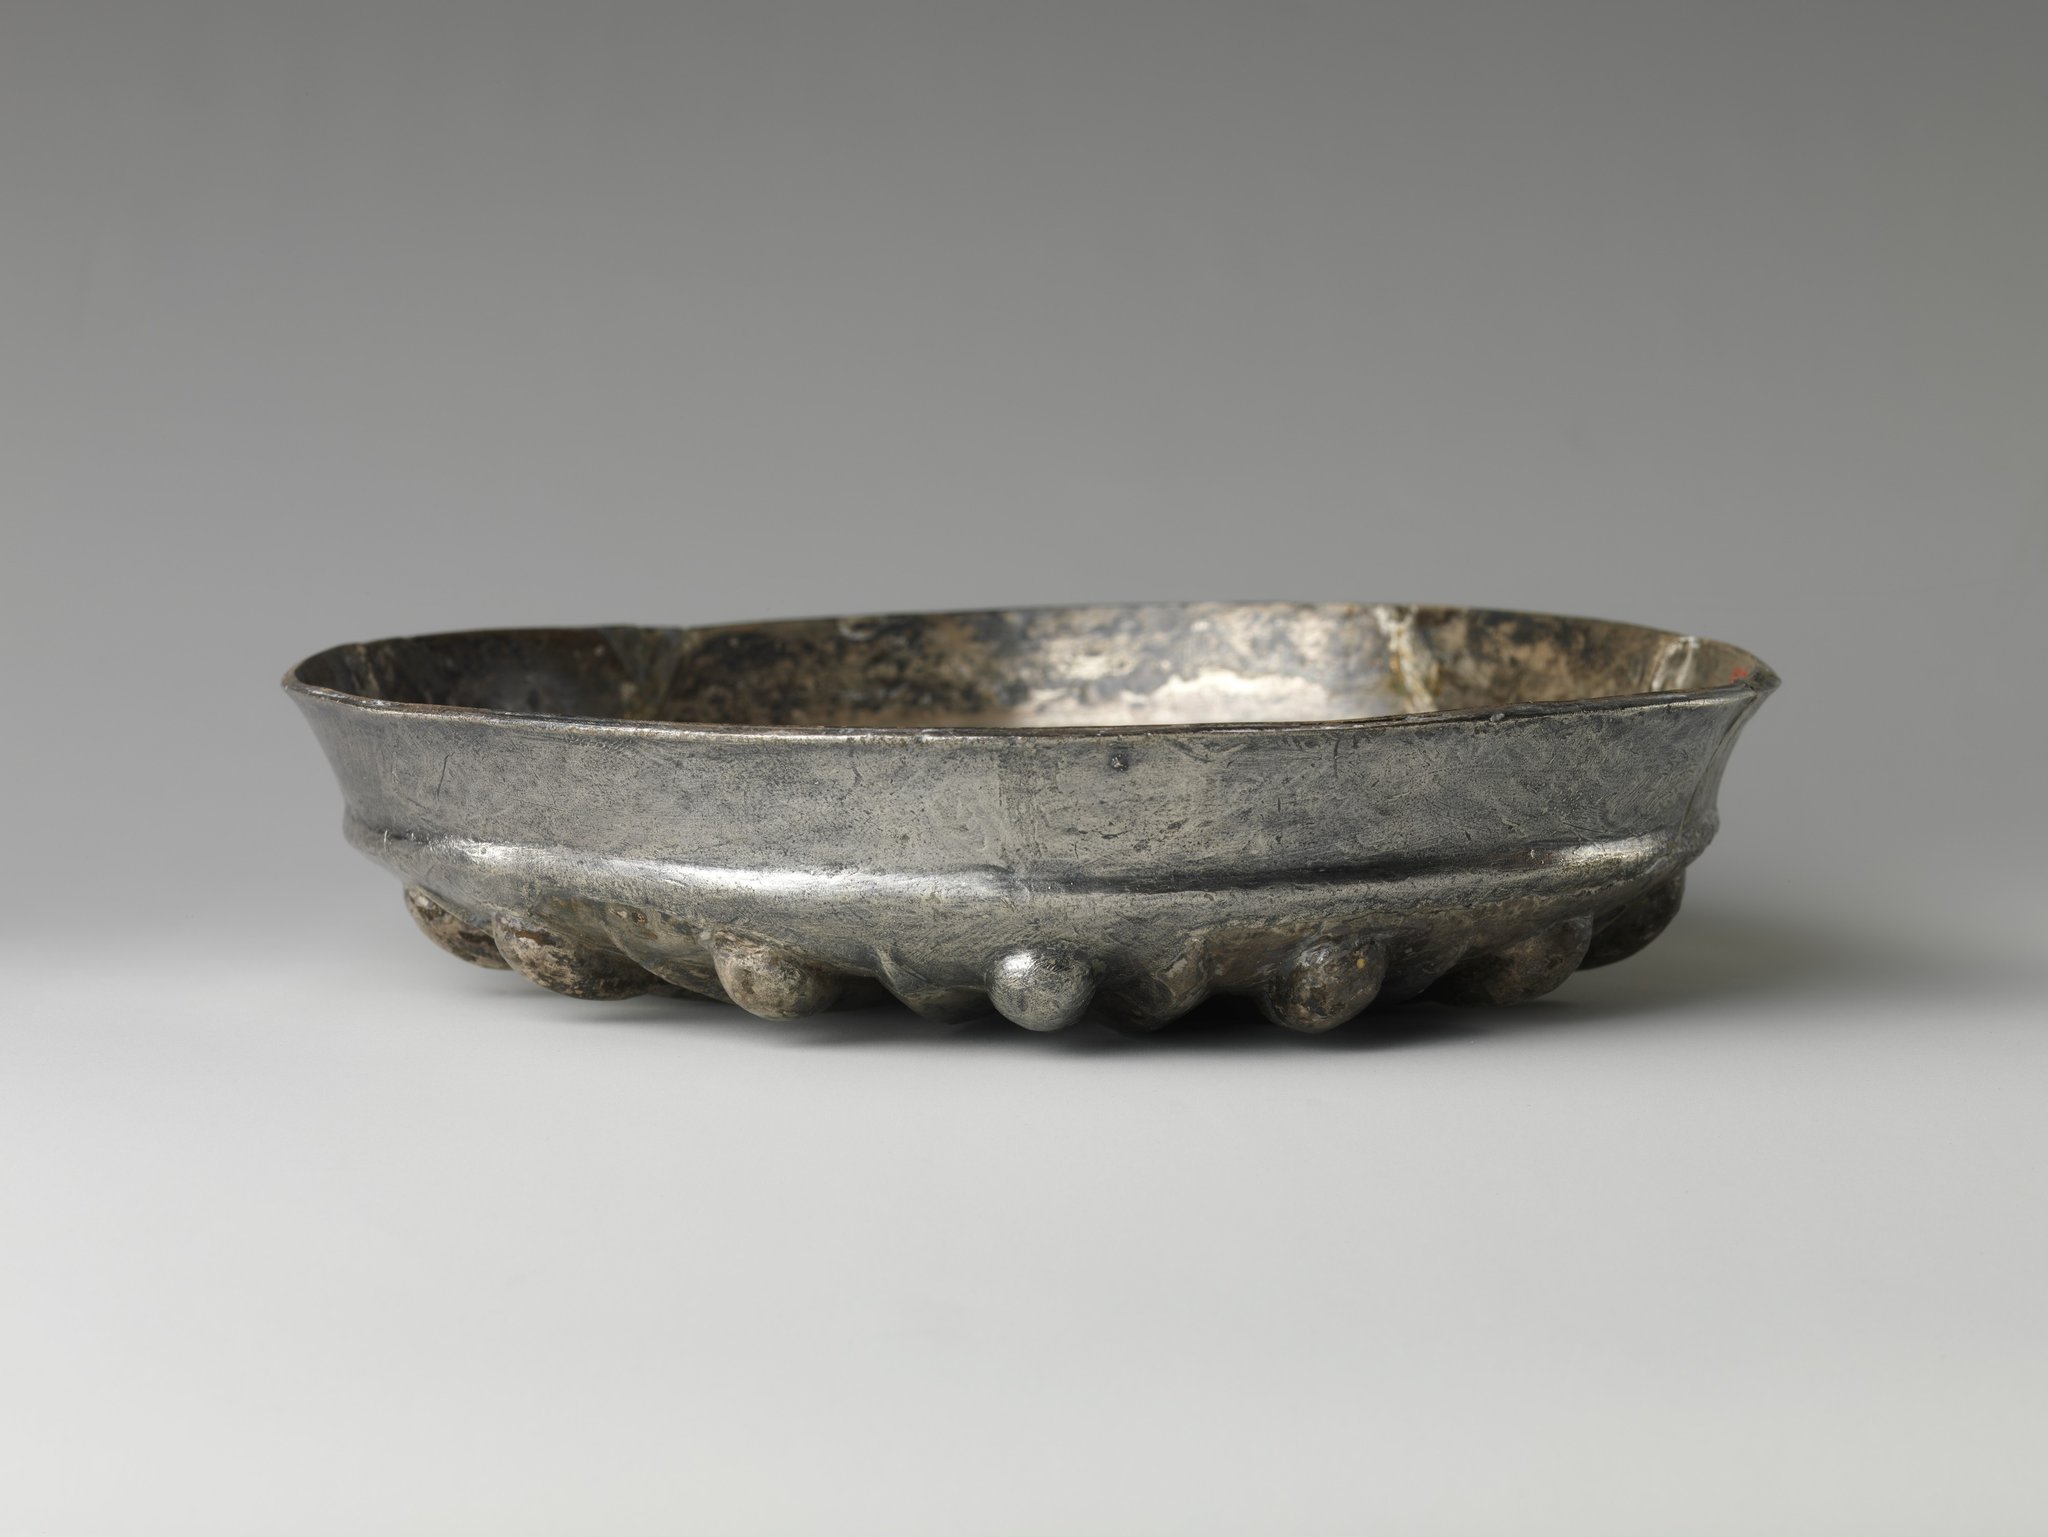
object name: bowl, boss, petal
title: Bowl with bosses and petals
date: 400-301 BCE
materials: silver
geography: egypt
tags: flowers